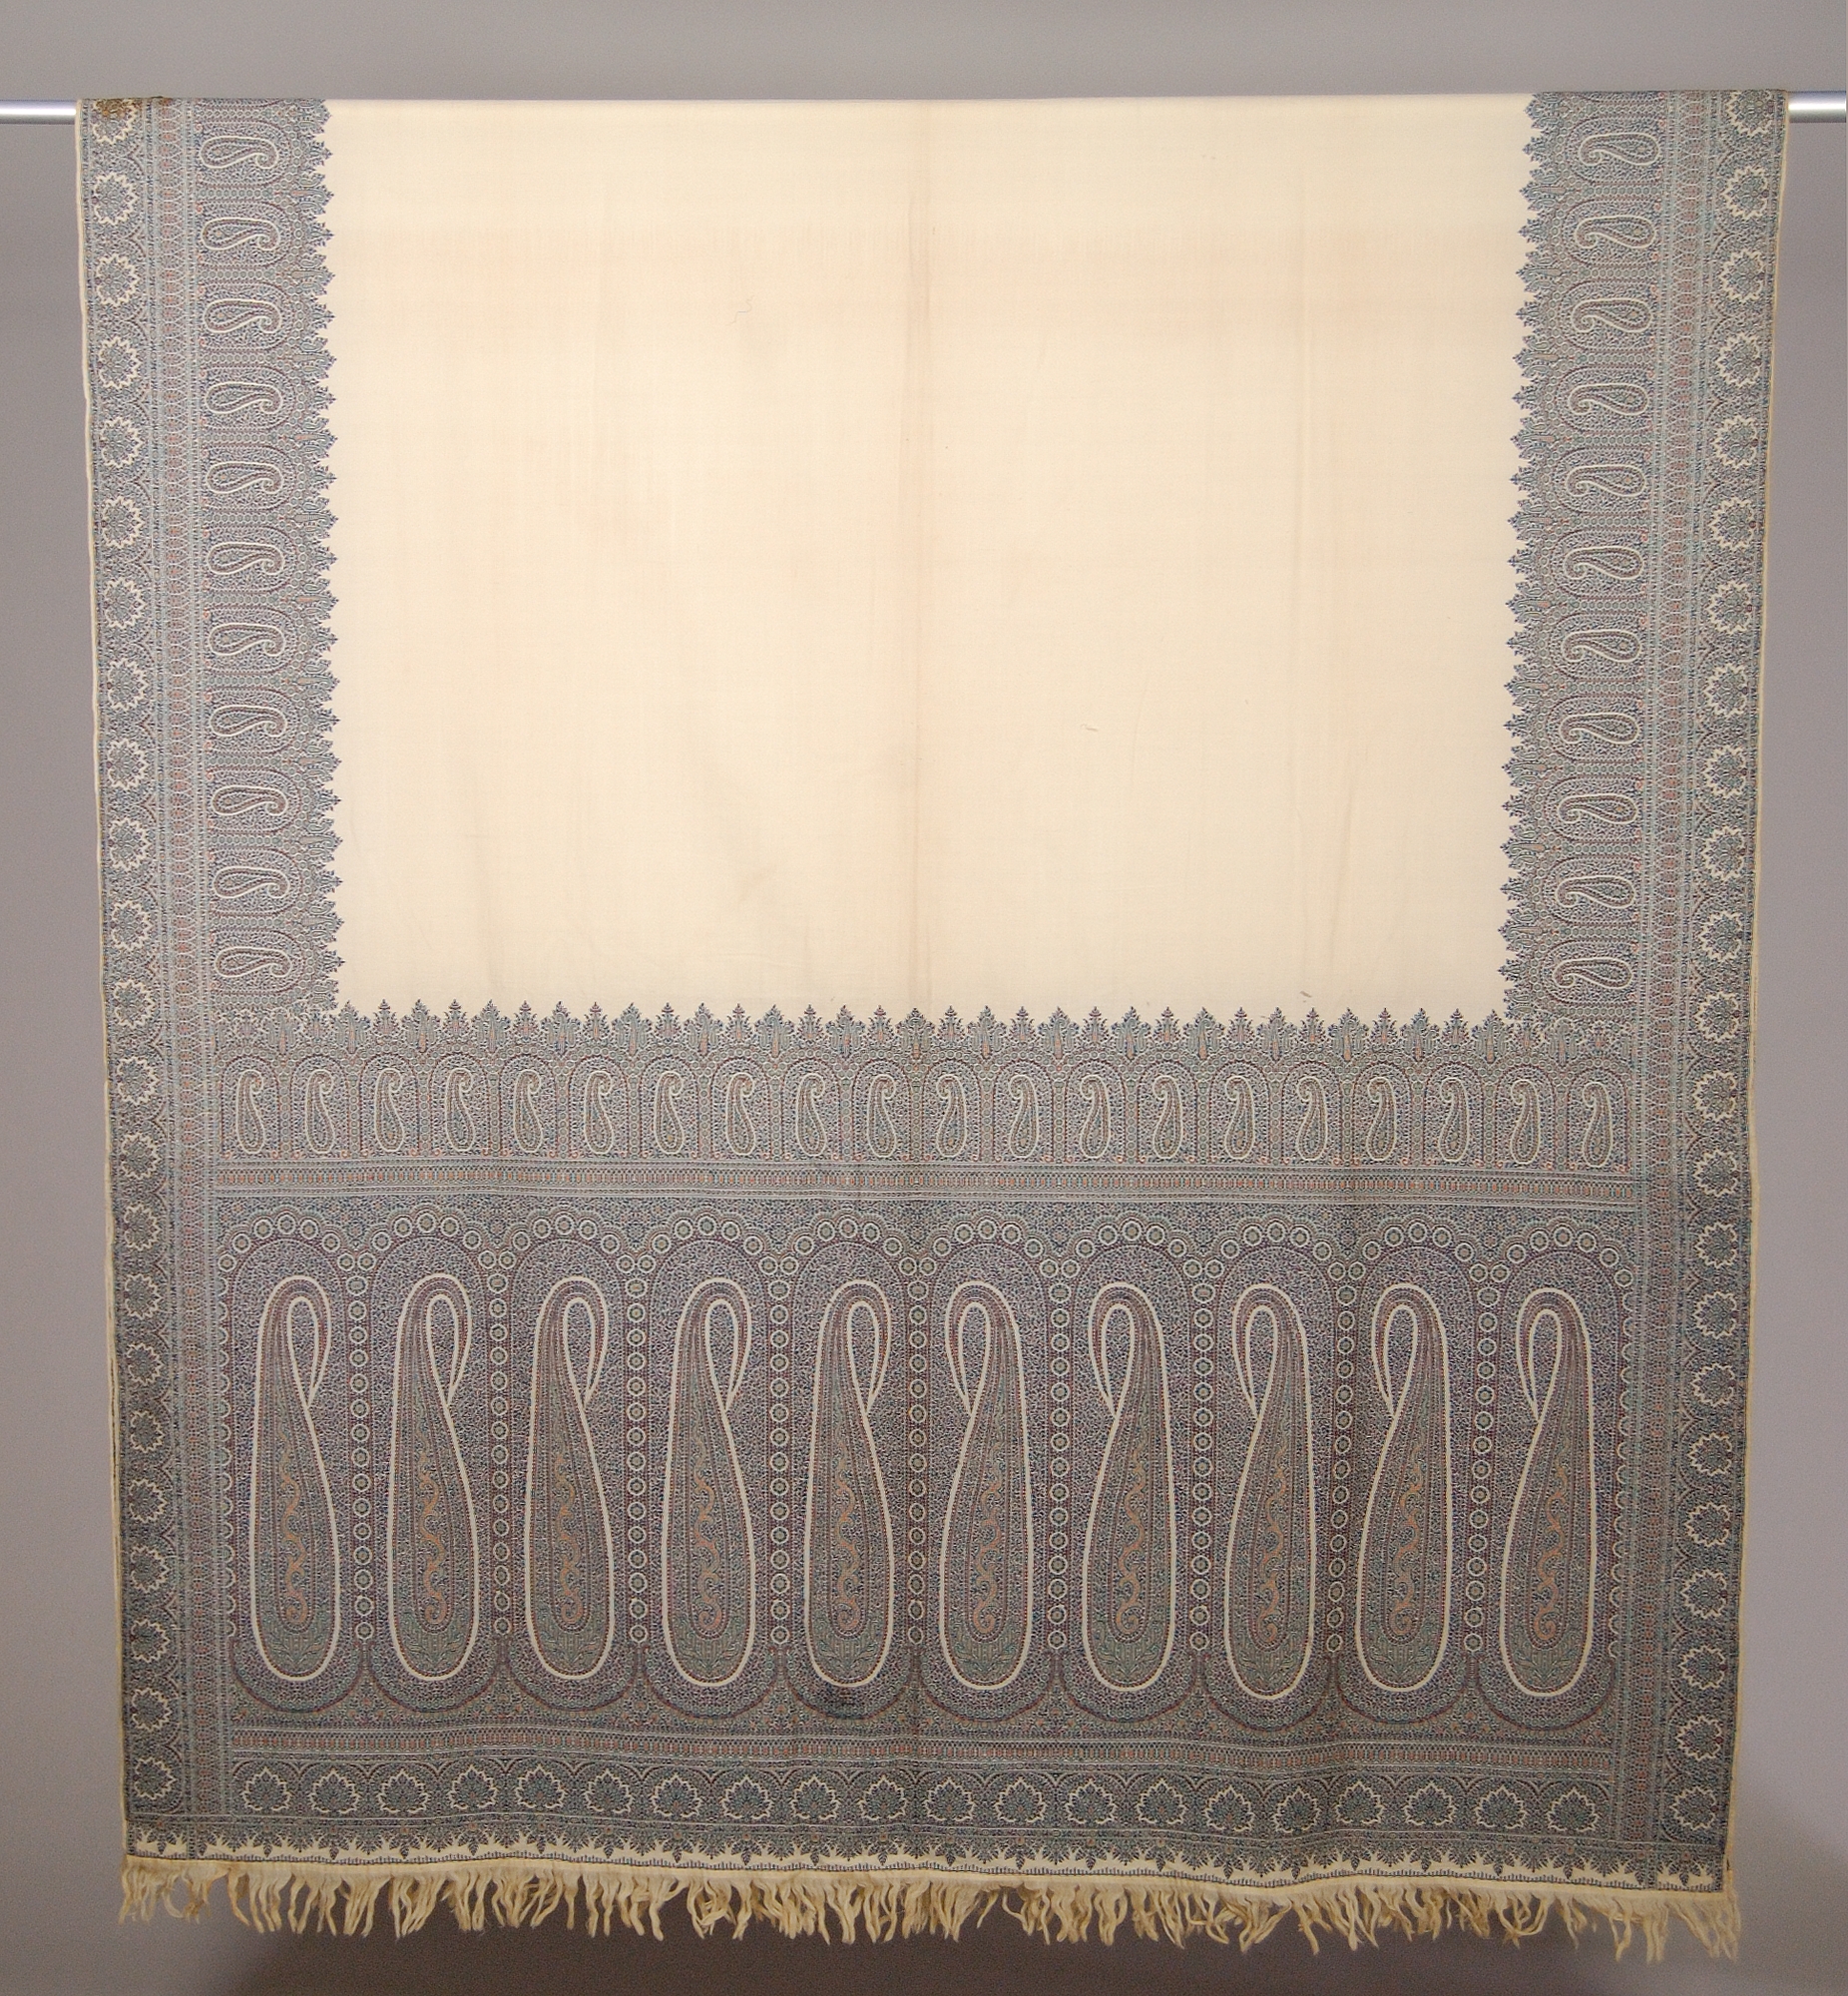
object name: shawl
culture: scottish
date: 1850-1859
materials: wool